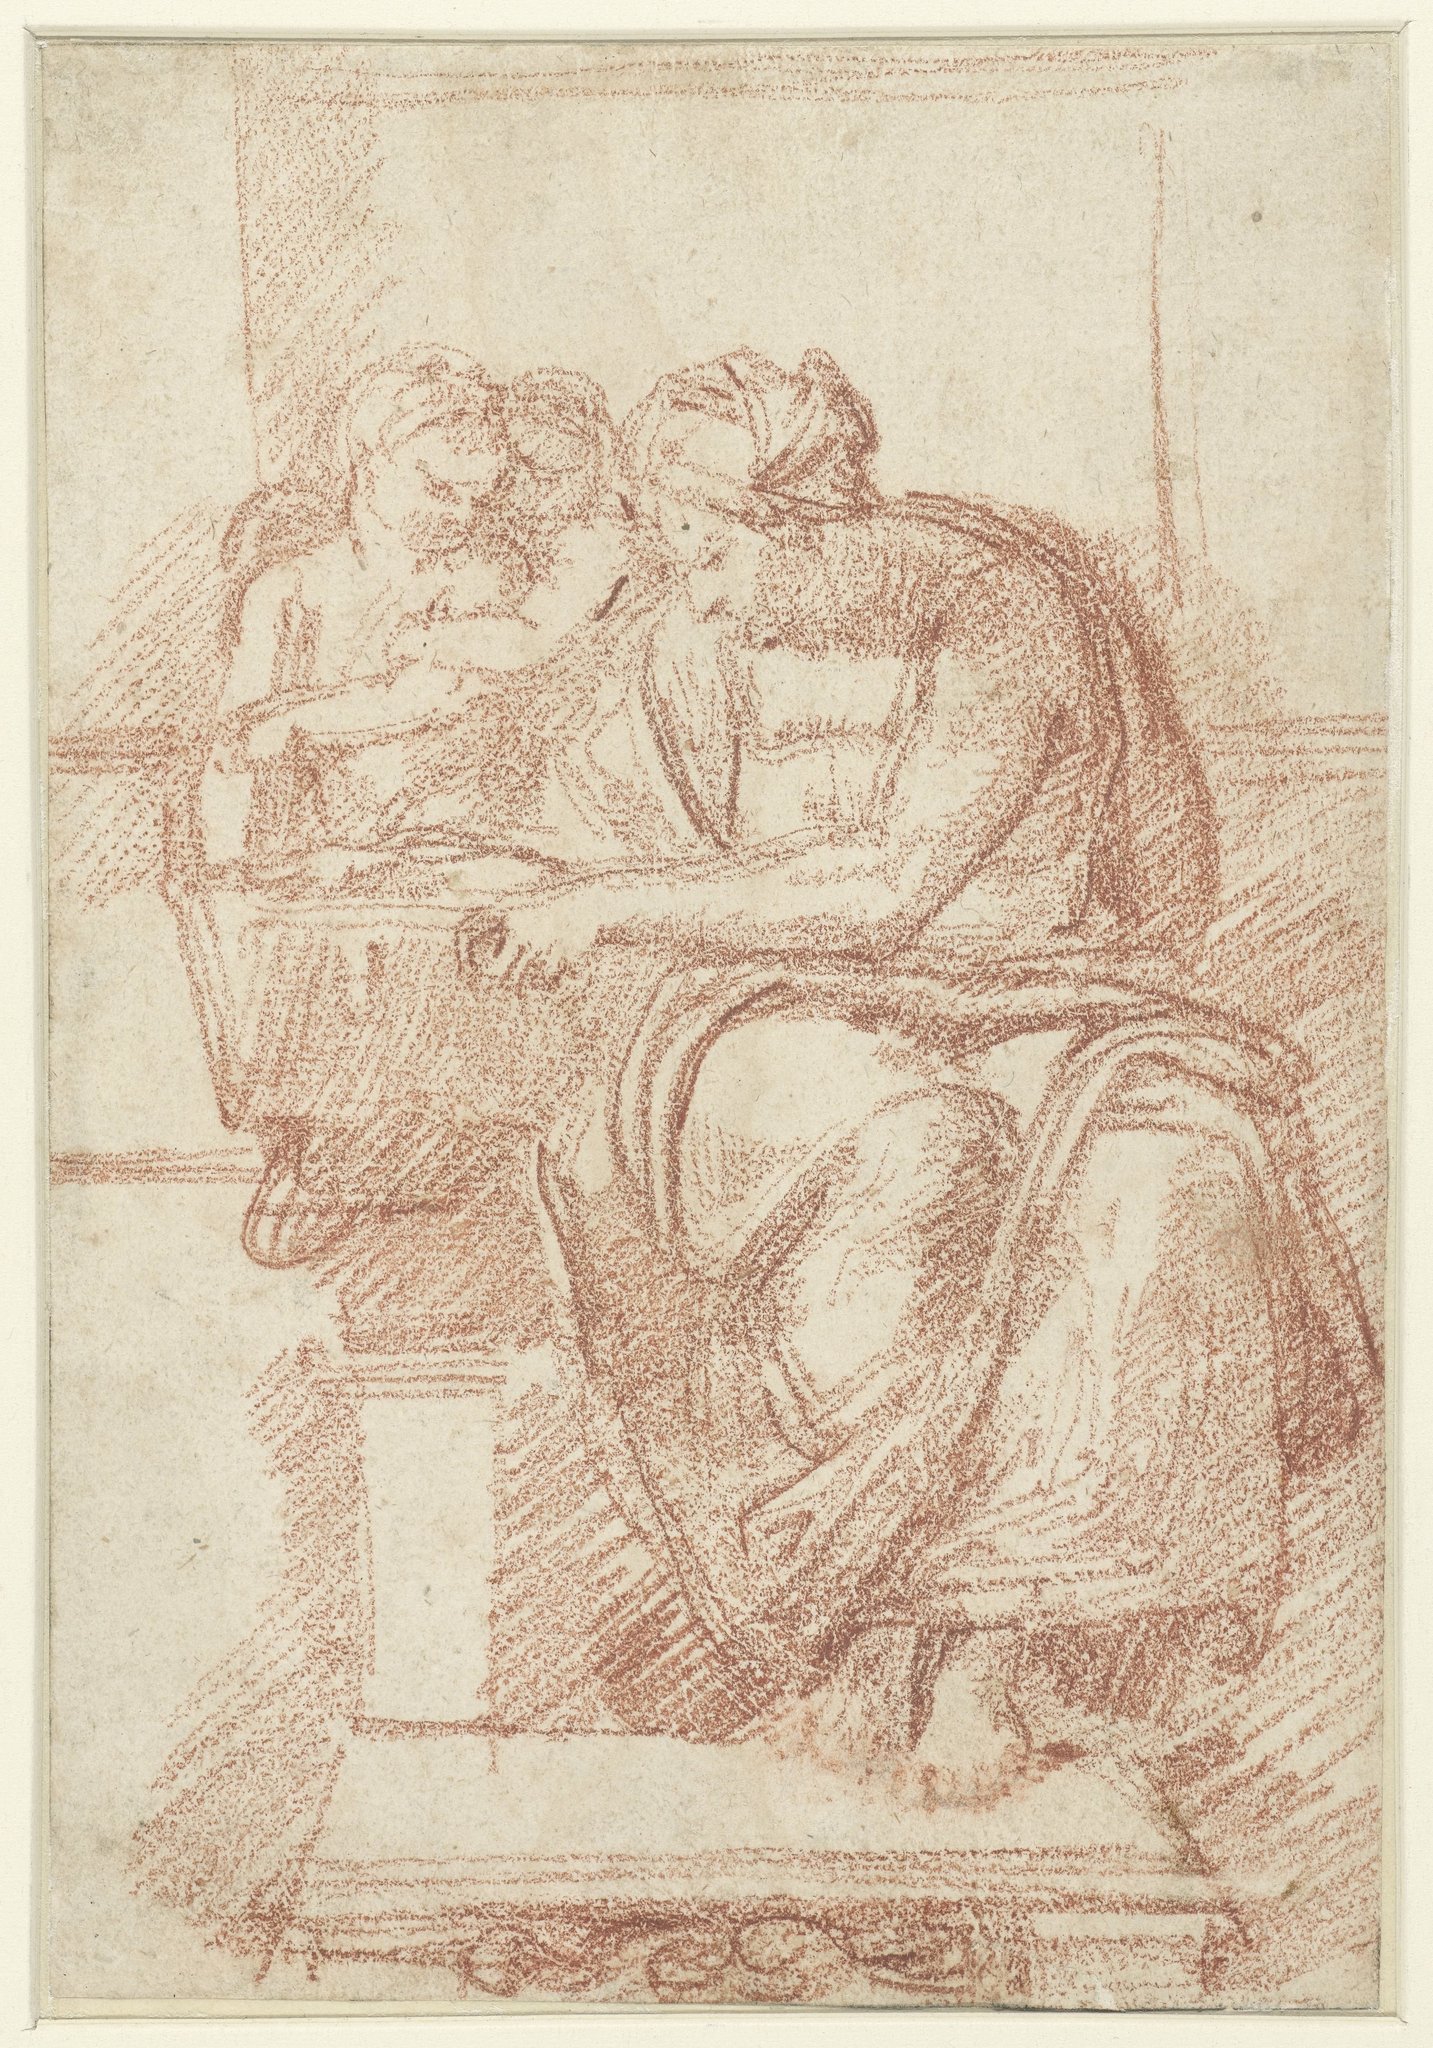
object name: drawing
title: Sibylle Cumaea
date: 1742-1806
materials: chalk, paper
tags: cumaean sibyl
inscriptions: collector's mark, verso, lower left: Lugt 2228, inscription, verso, lower, pencil: ‘Sibylla / CUMAIA / [chapelle sixtine]’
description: Kopie naar de sibylle Cumaea in de Sixtijnse kapel.